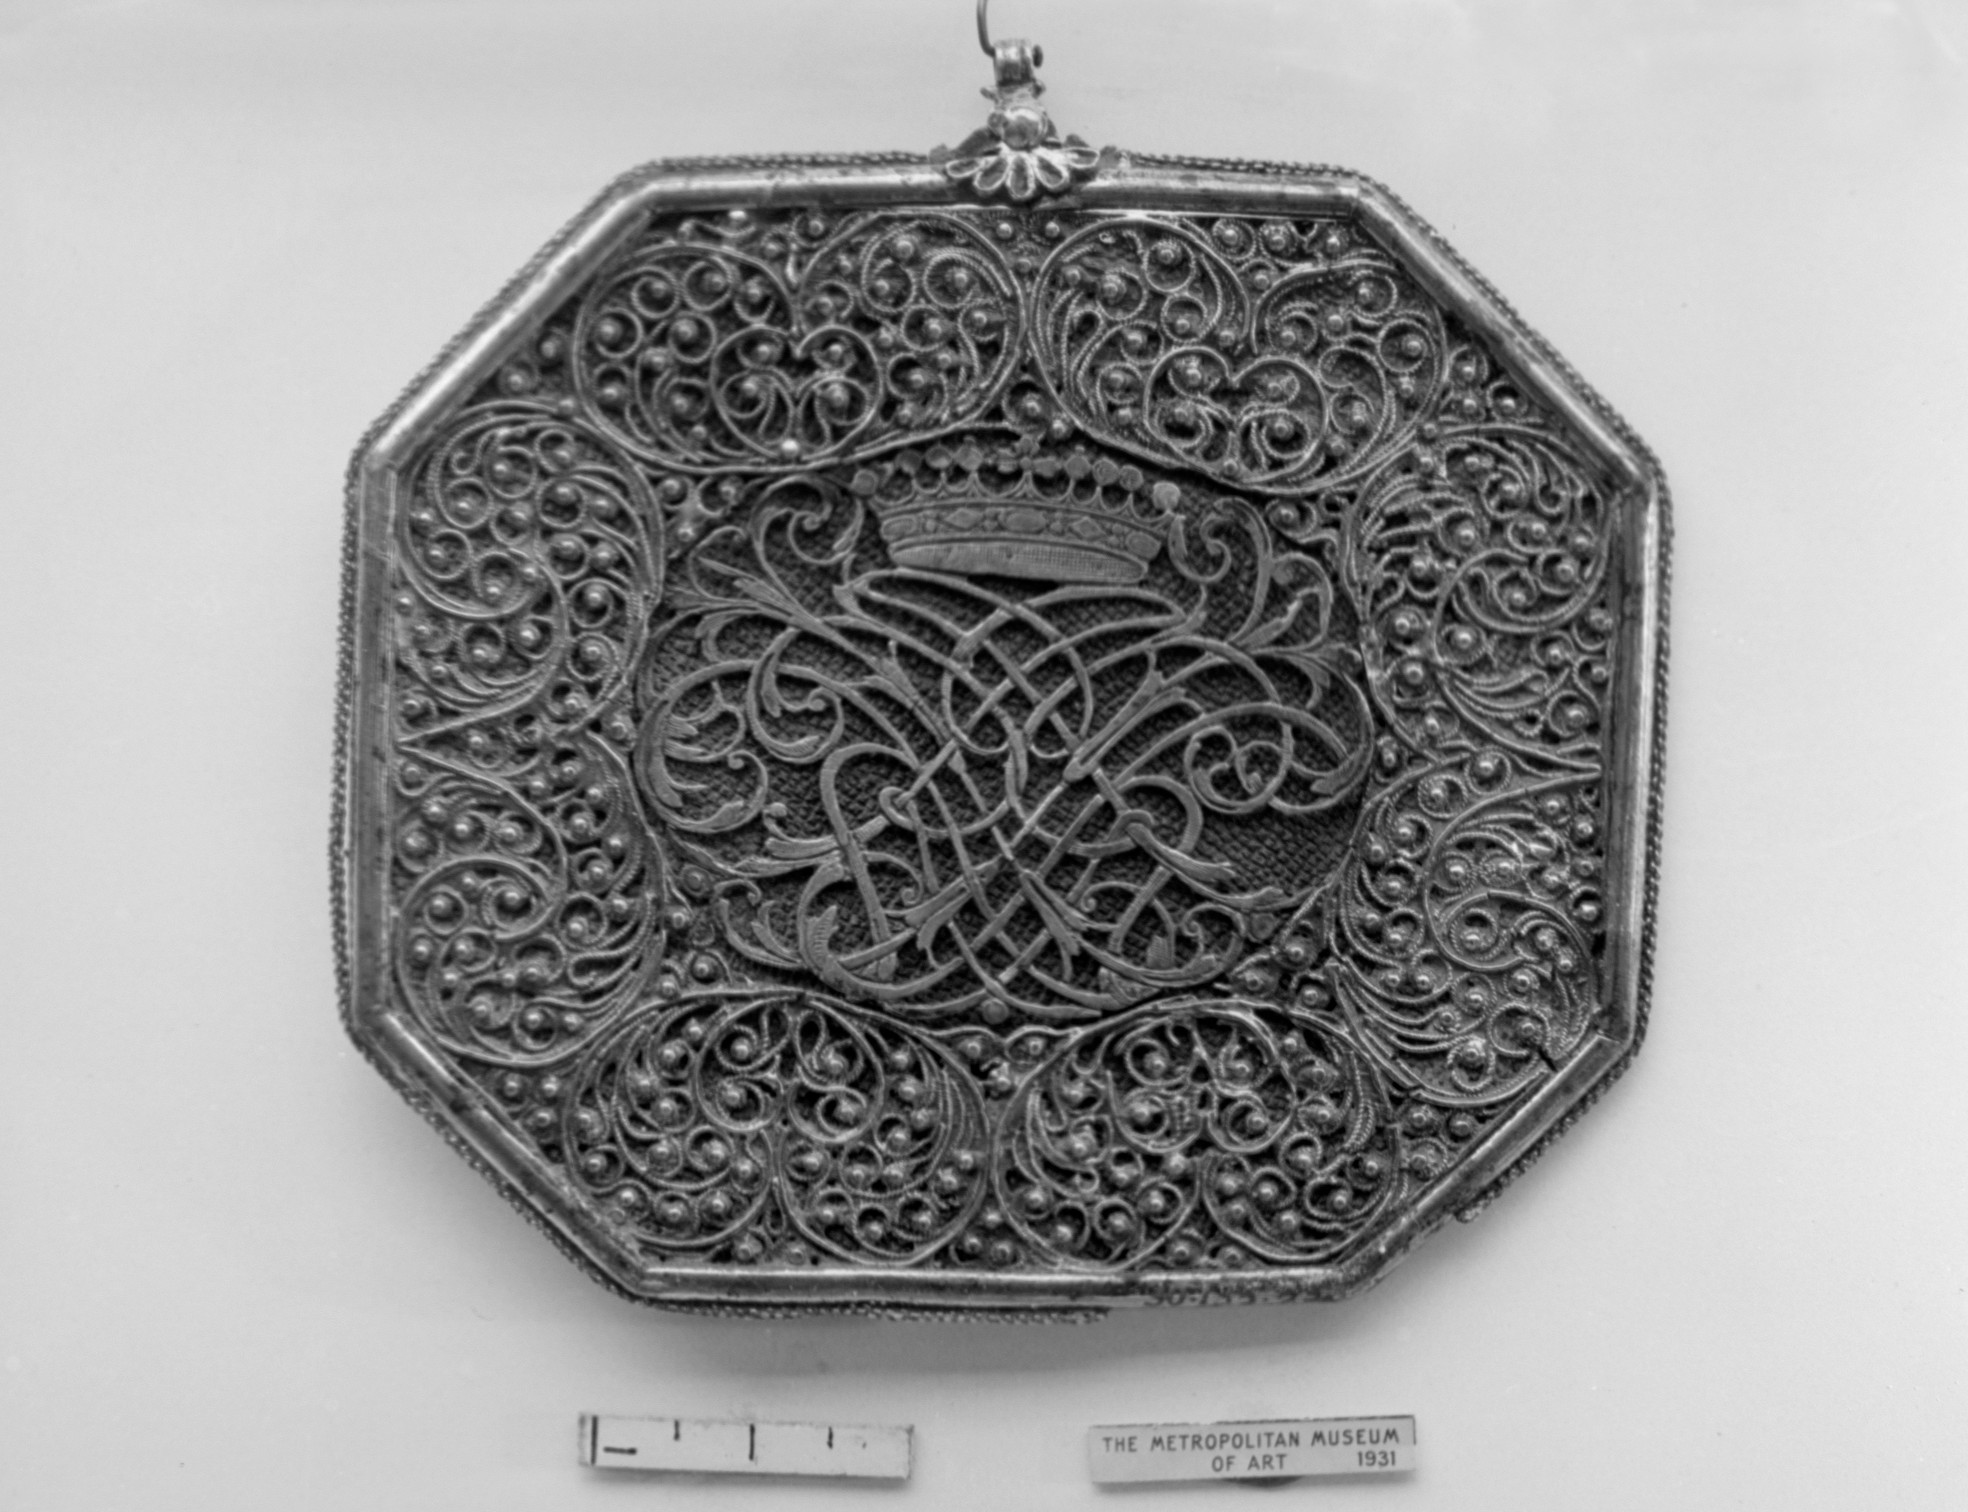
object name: mirror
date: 1601-1700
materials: copper gilt, silver